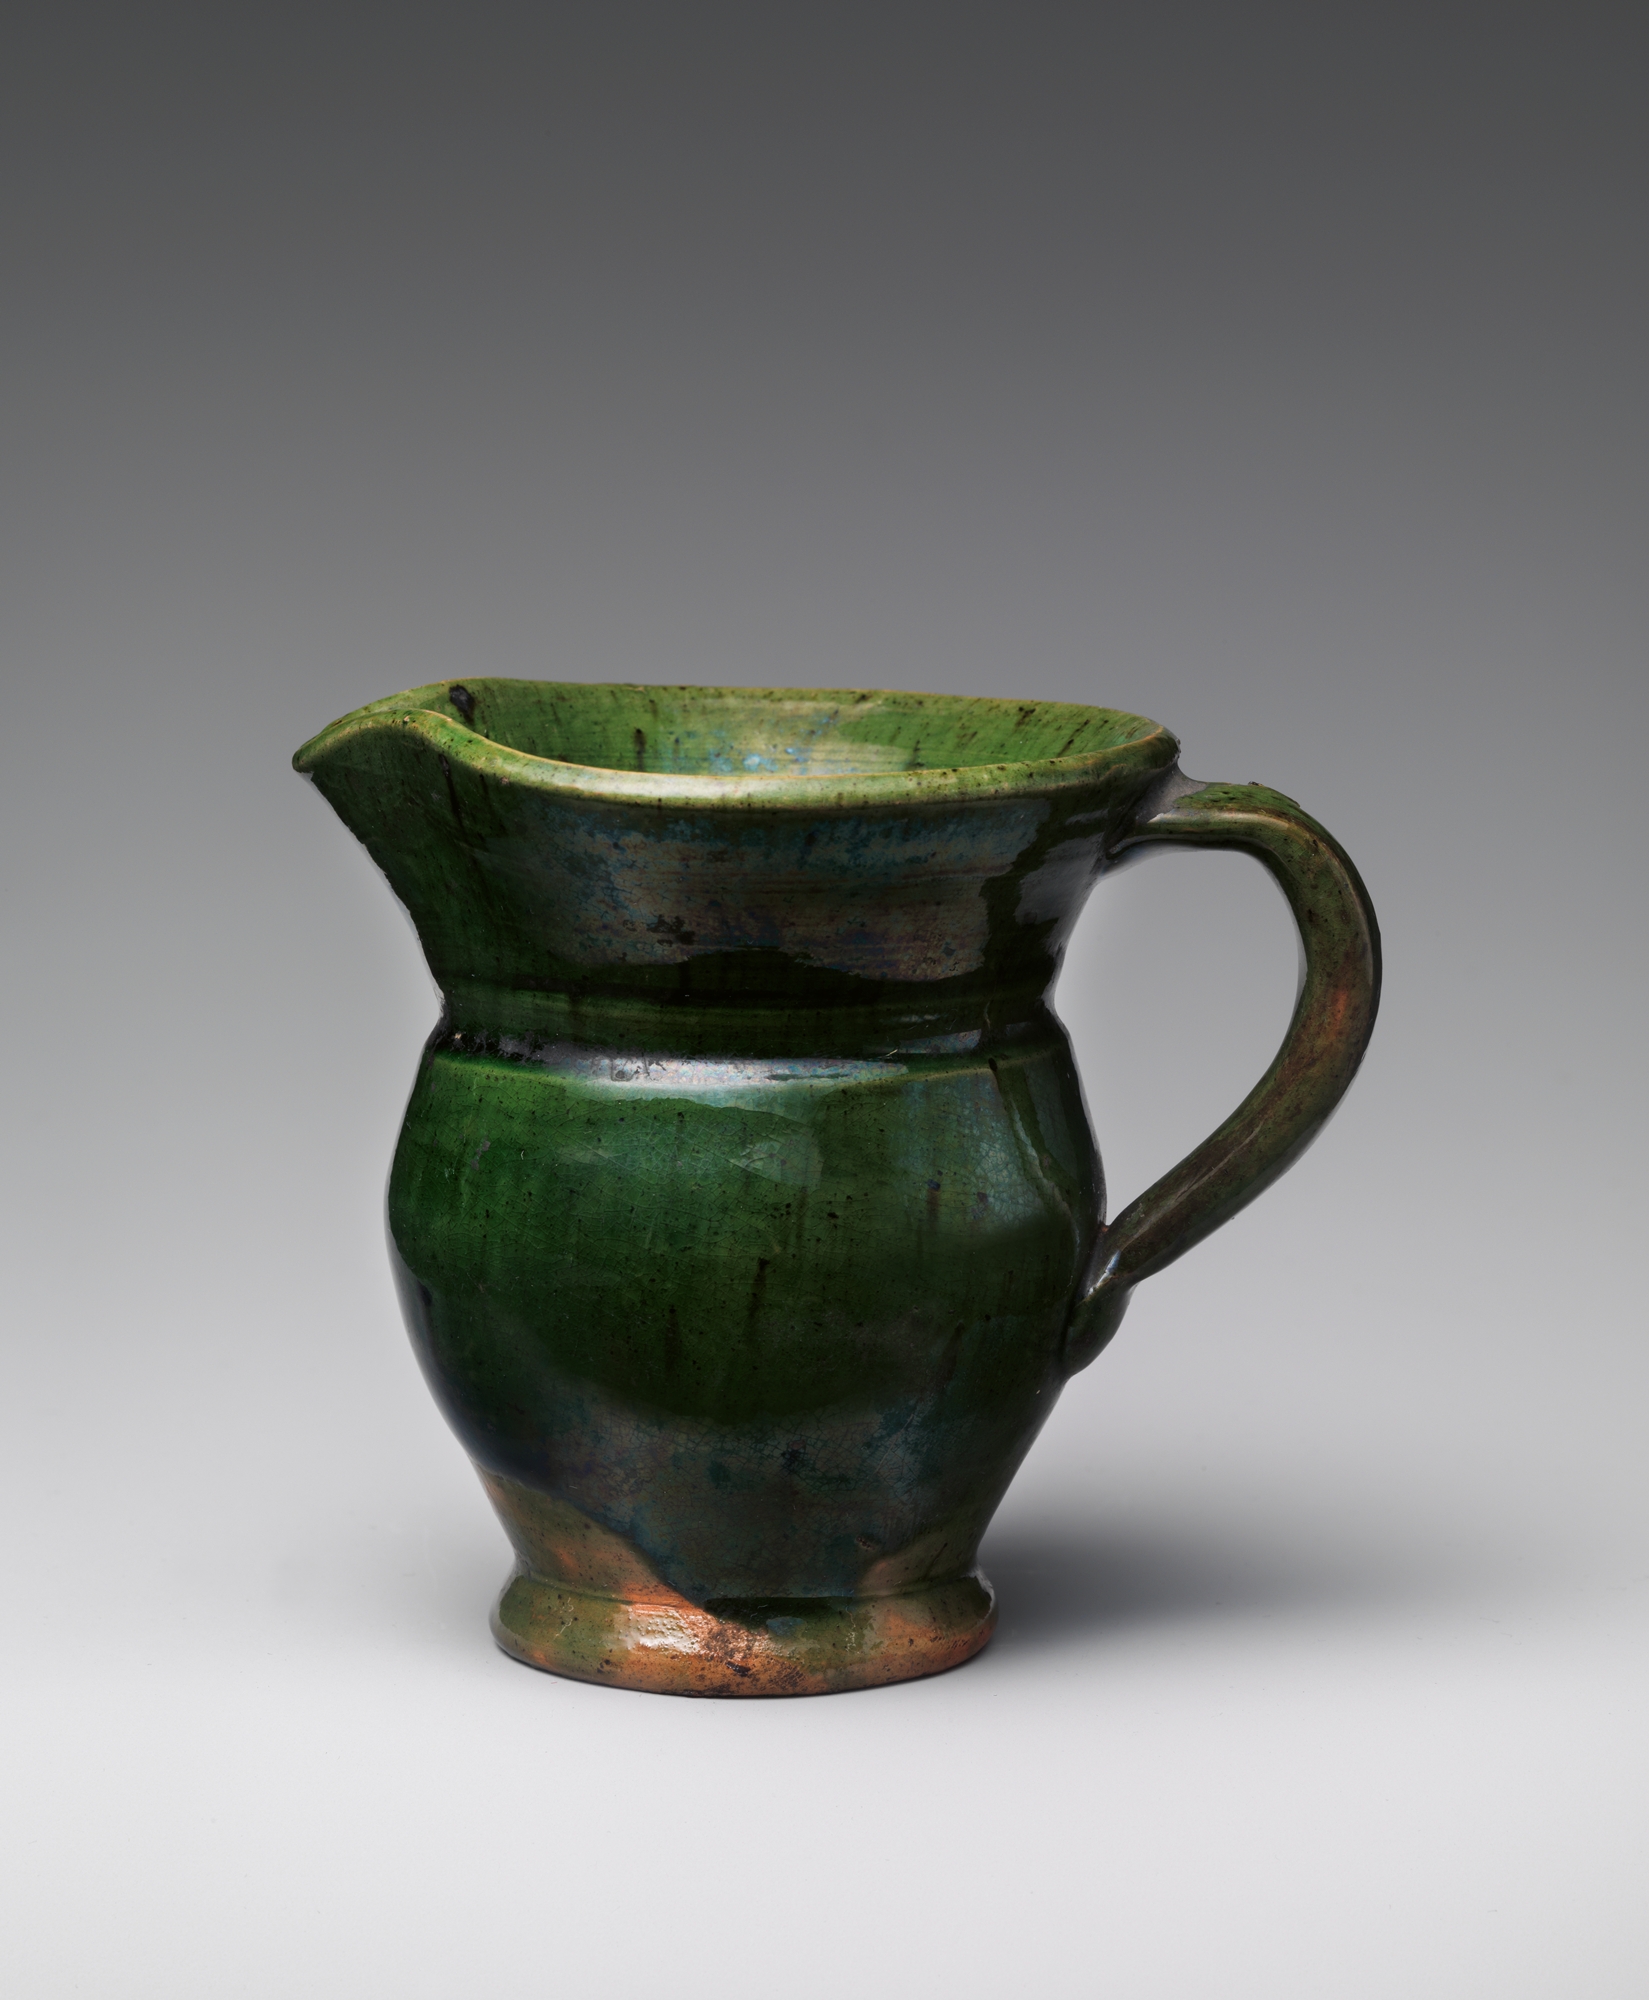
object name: pitcher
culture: american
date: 1800-1900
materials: earthenware